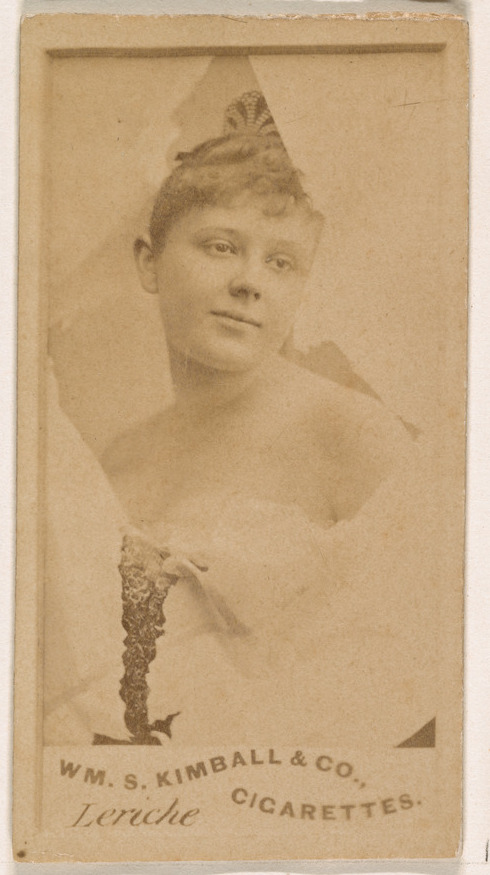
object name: photograph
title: Miss Leriche, from the Actresses series (N203) issued by Wm. S. Kimball & Co.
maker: william s. kimball & company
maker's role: publisher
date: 1889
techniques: color lithograph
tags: portraits,women,actresses